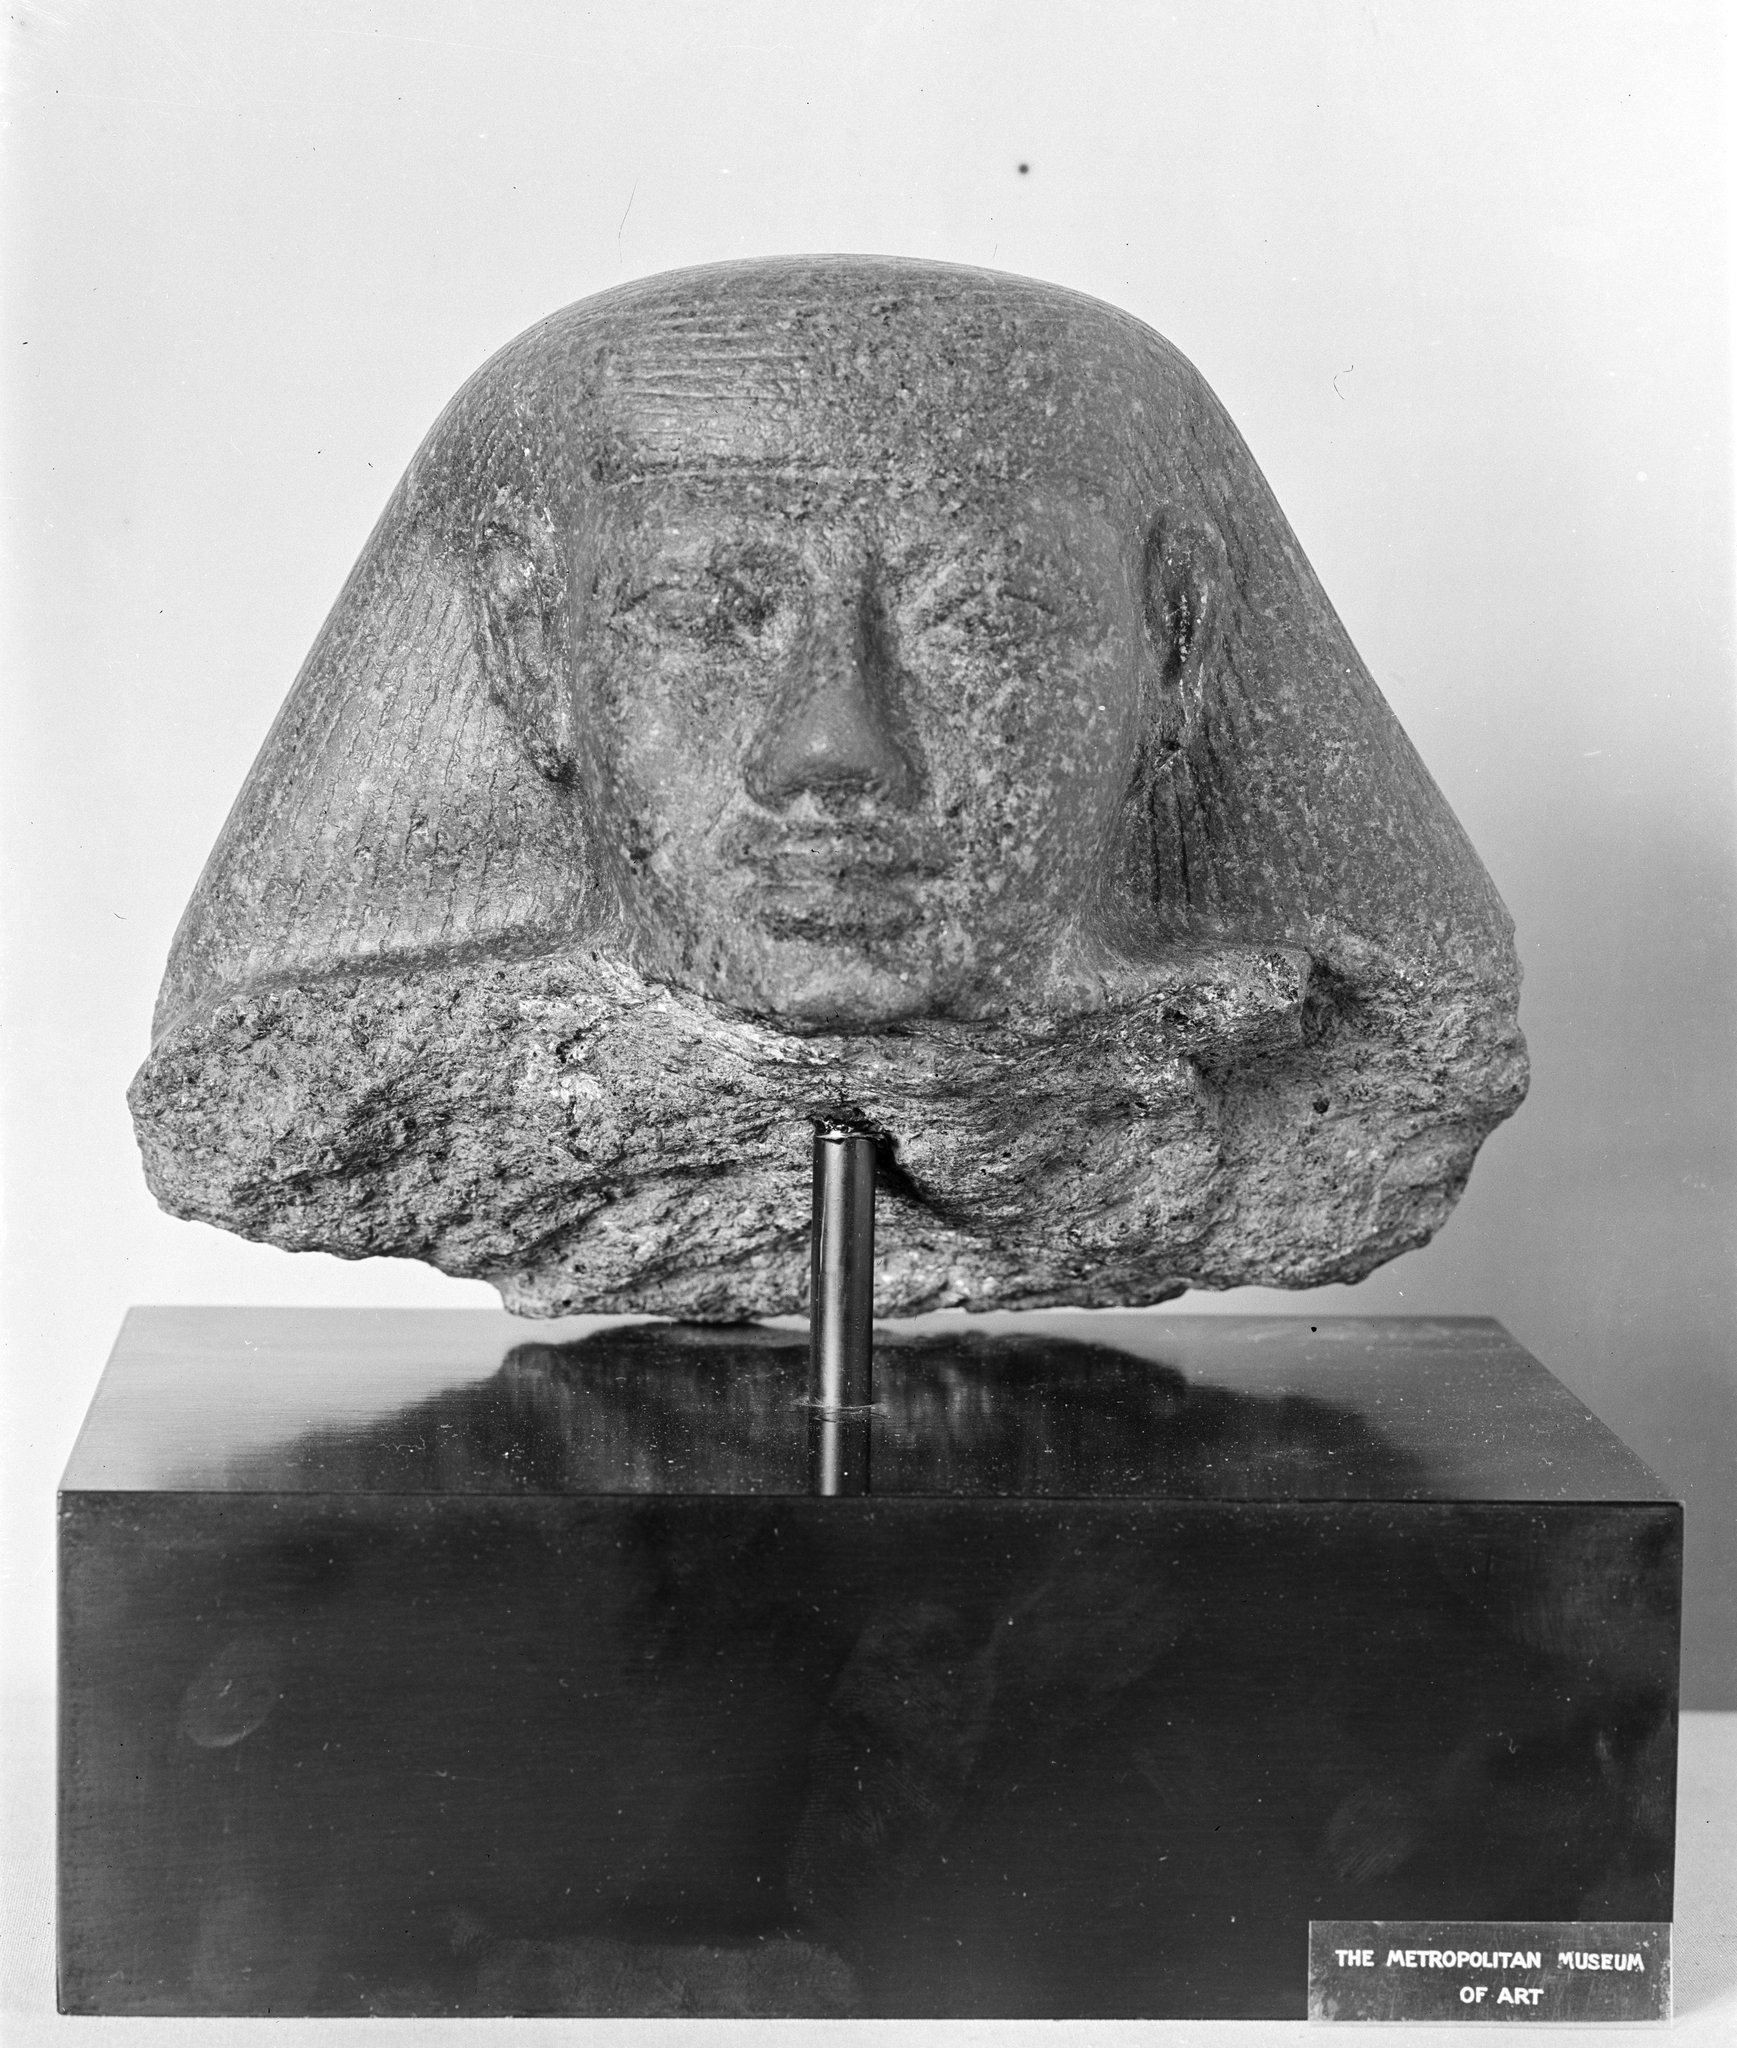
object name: block statue head, mentuhotep, chief of scribe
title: Head from a Block Statue of Mentuhotep, lower part in the University of Tubingen museum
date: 690-610 BCE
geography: egypt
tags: heads,men